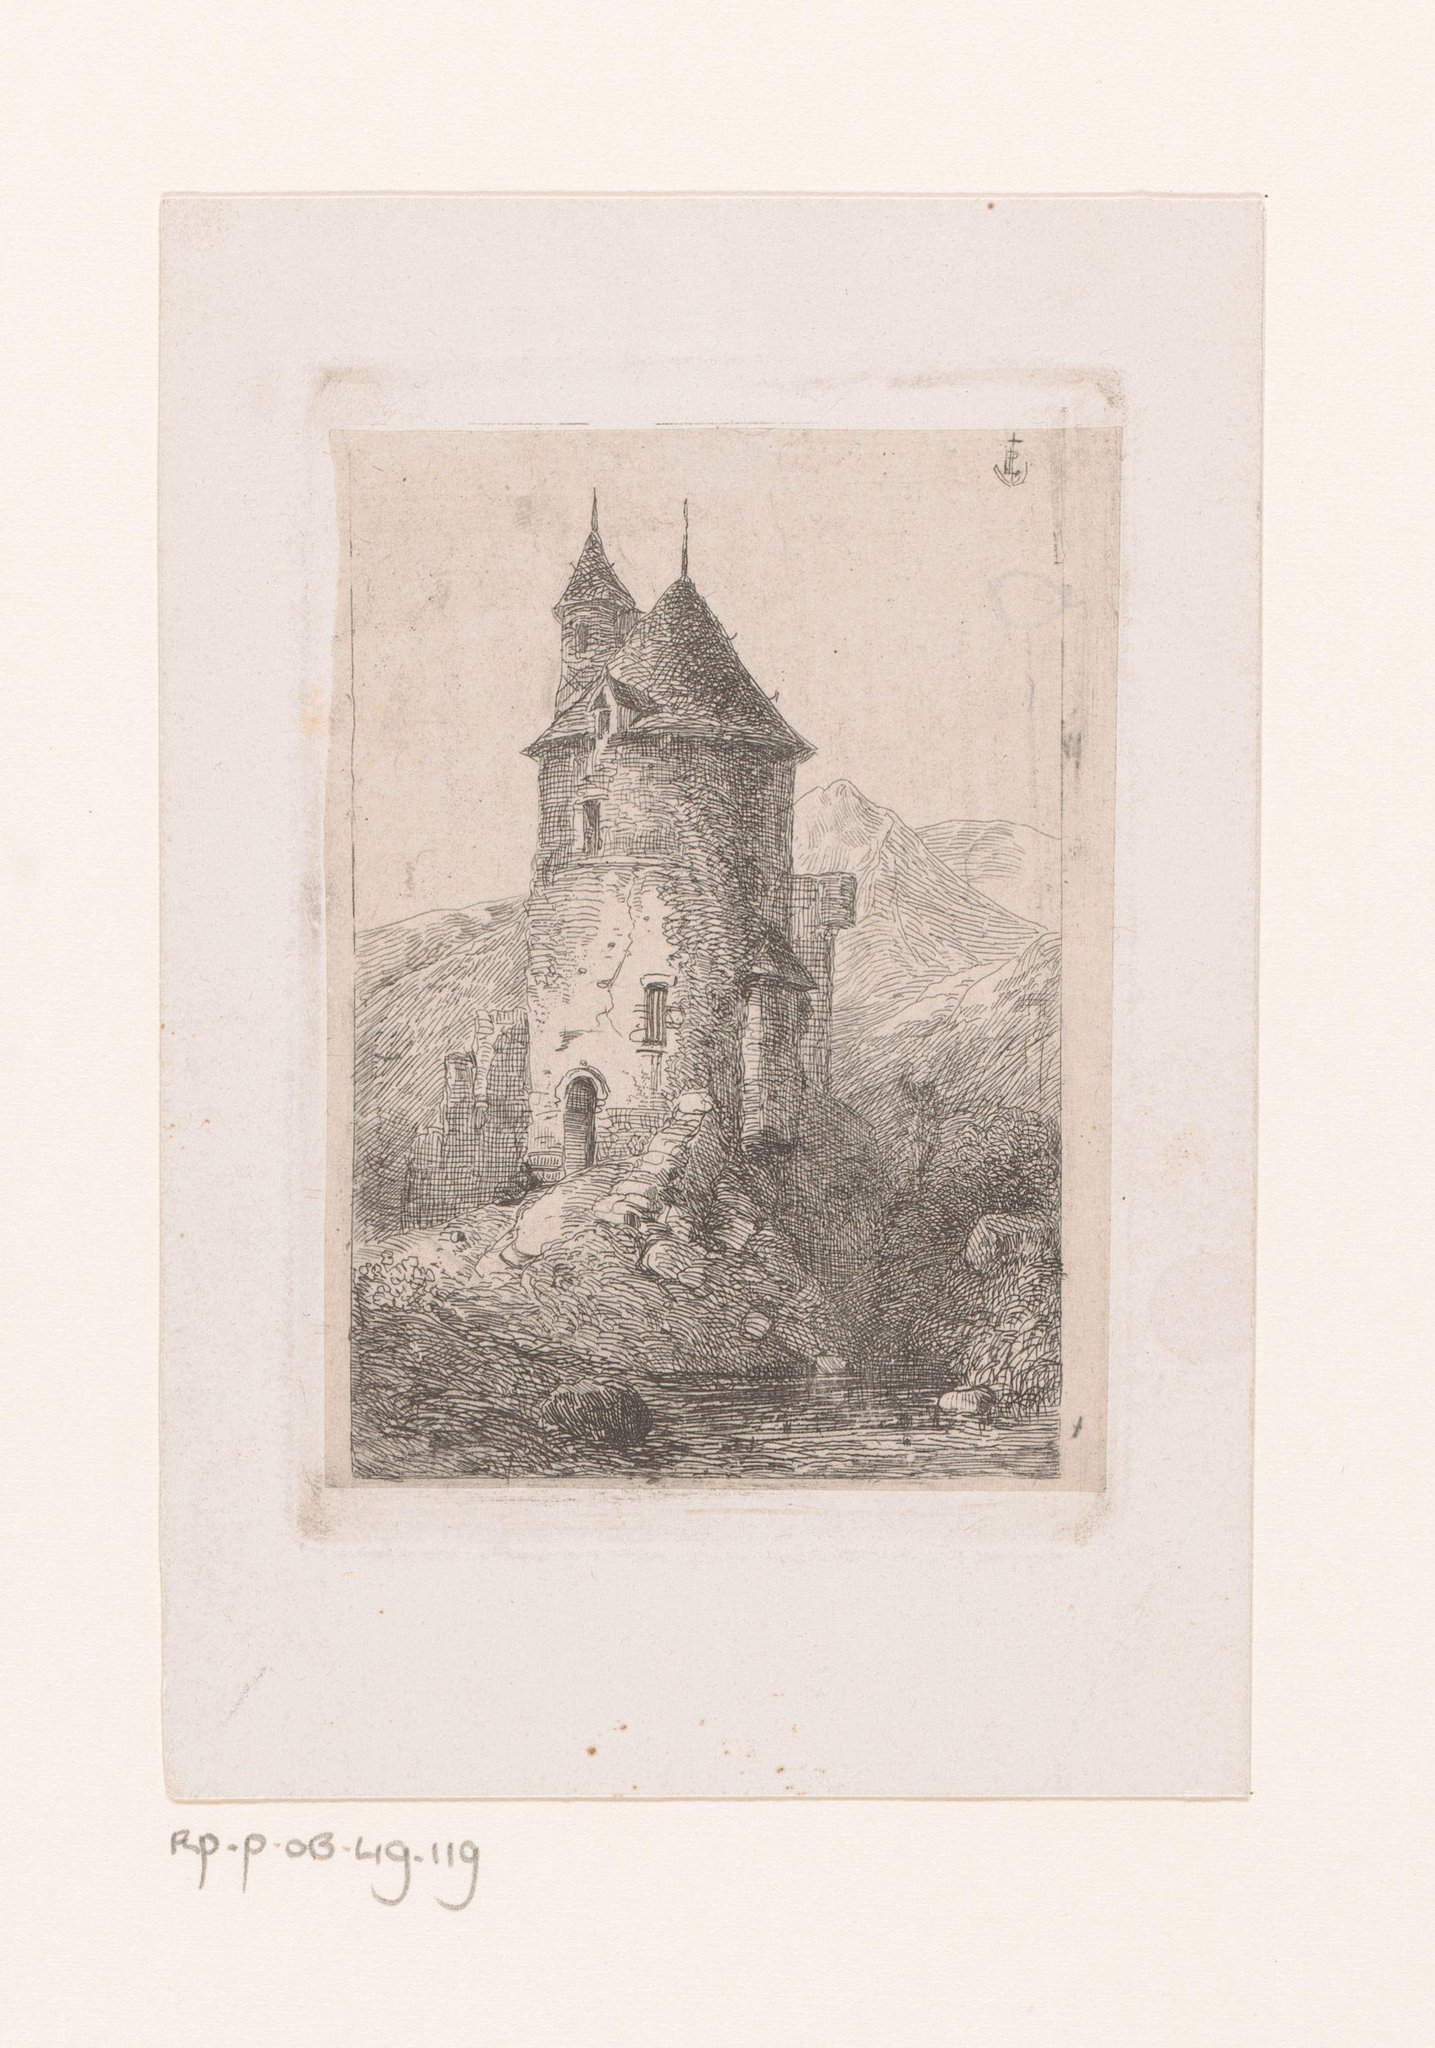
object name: print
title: Bouwvallige toren in bergachtig landschap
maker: paulus lauters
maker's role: print maker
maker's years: 1806-1875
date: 1816-1875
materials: paper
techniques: etching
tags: landscape with tower or castle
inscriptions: collector's mark: Lugt 2228